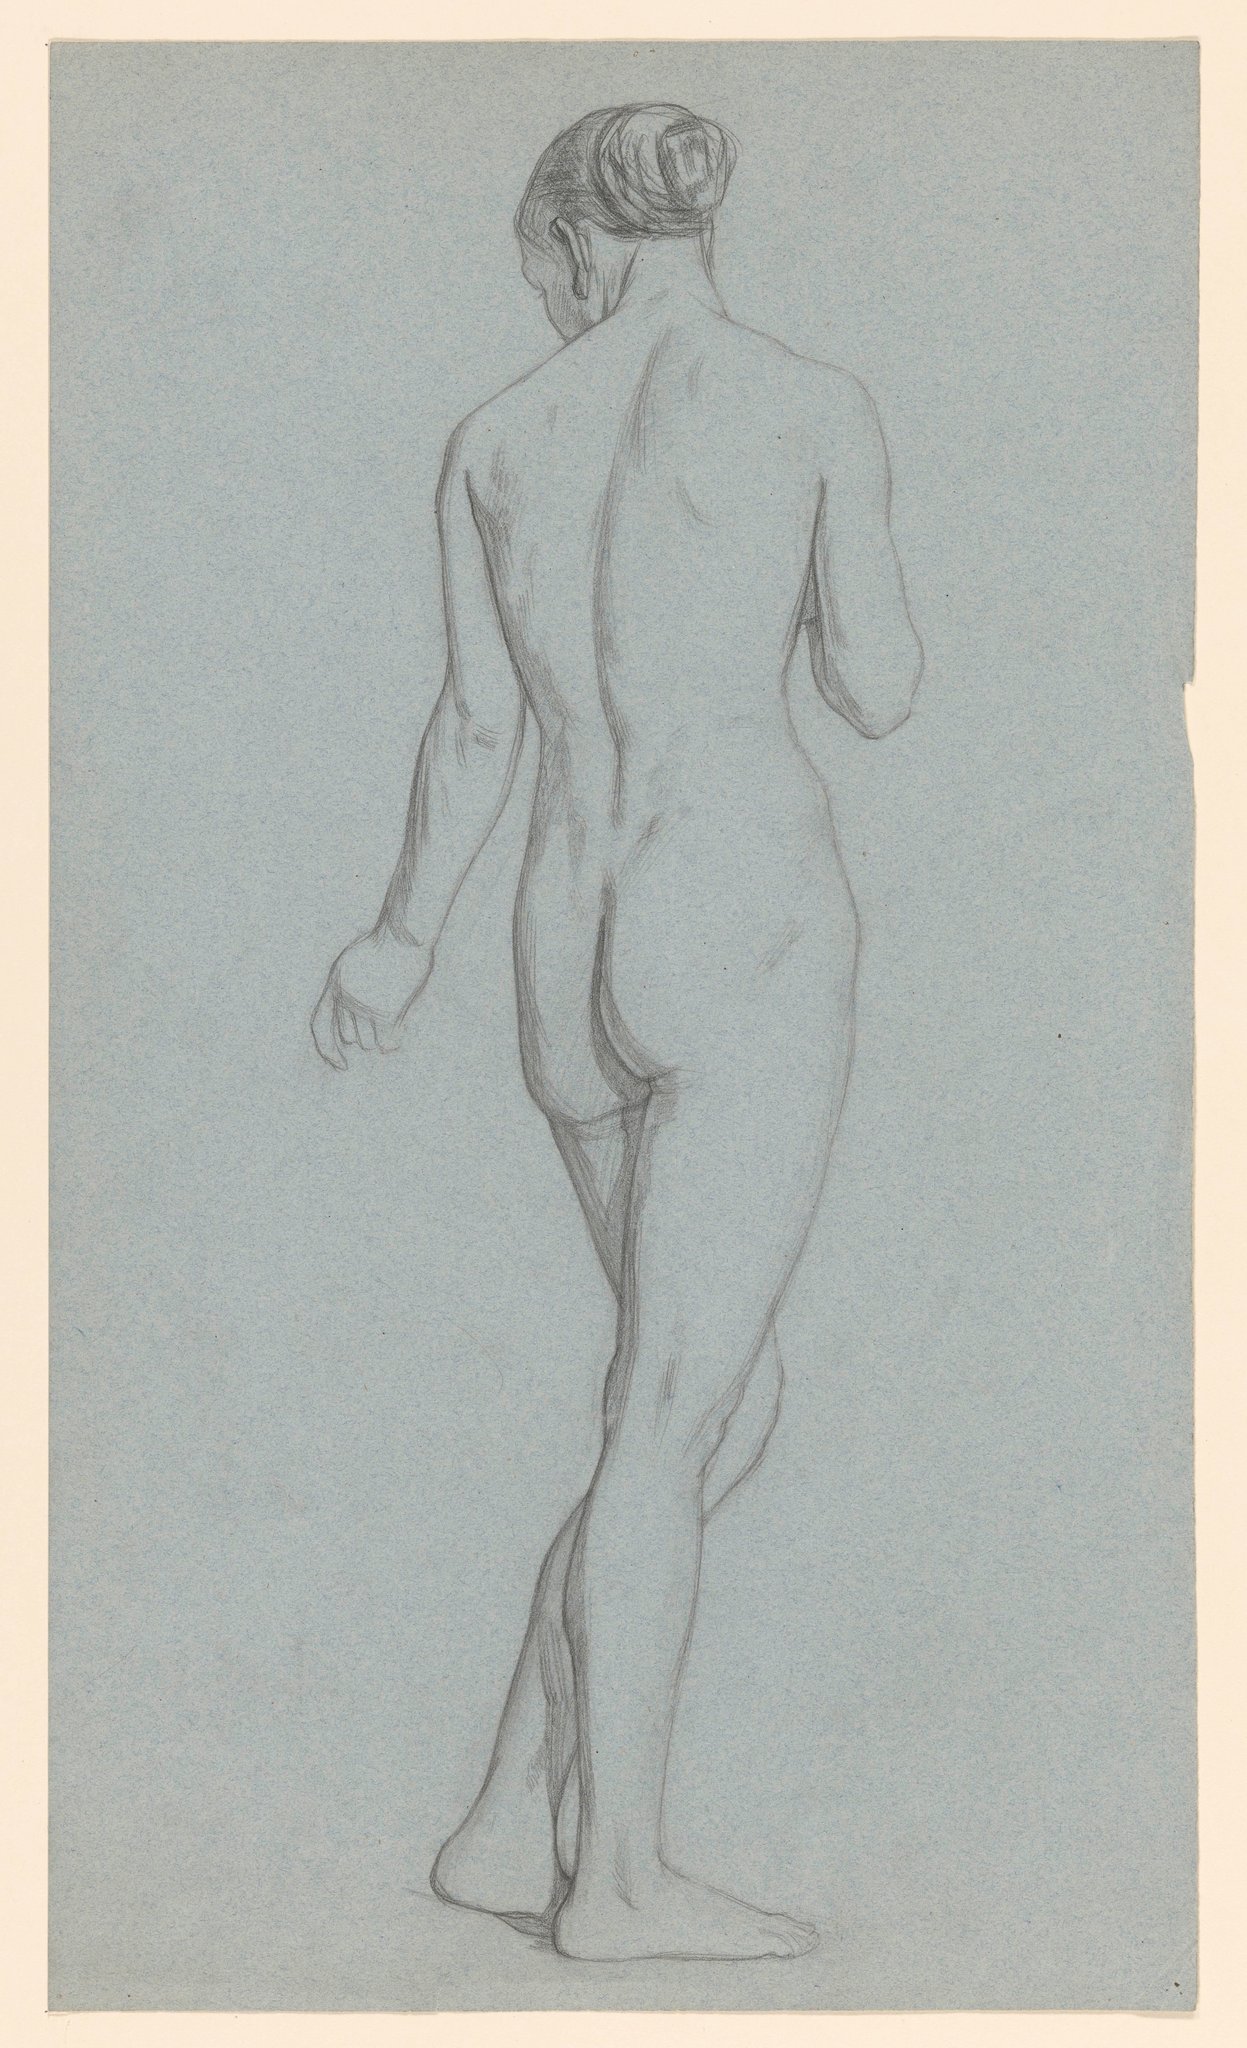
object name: drawing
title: Staand vrouwelijk naakt, op de rug gezien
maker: jan veth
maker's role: designer, draughtsman, painter, print maker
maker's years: 1864-1925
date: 1874-1925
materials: chalk, paper